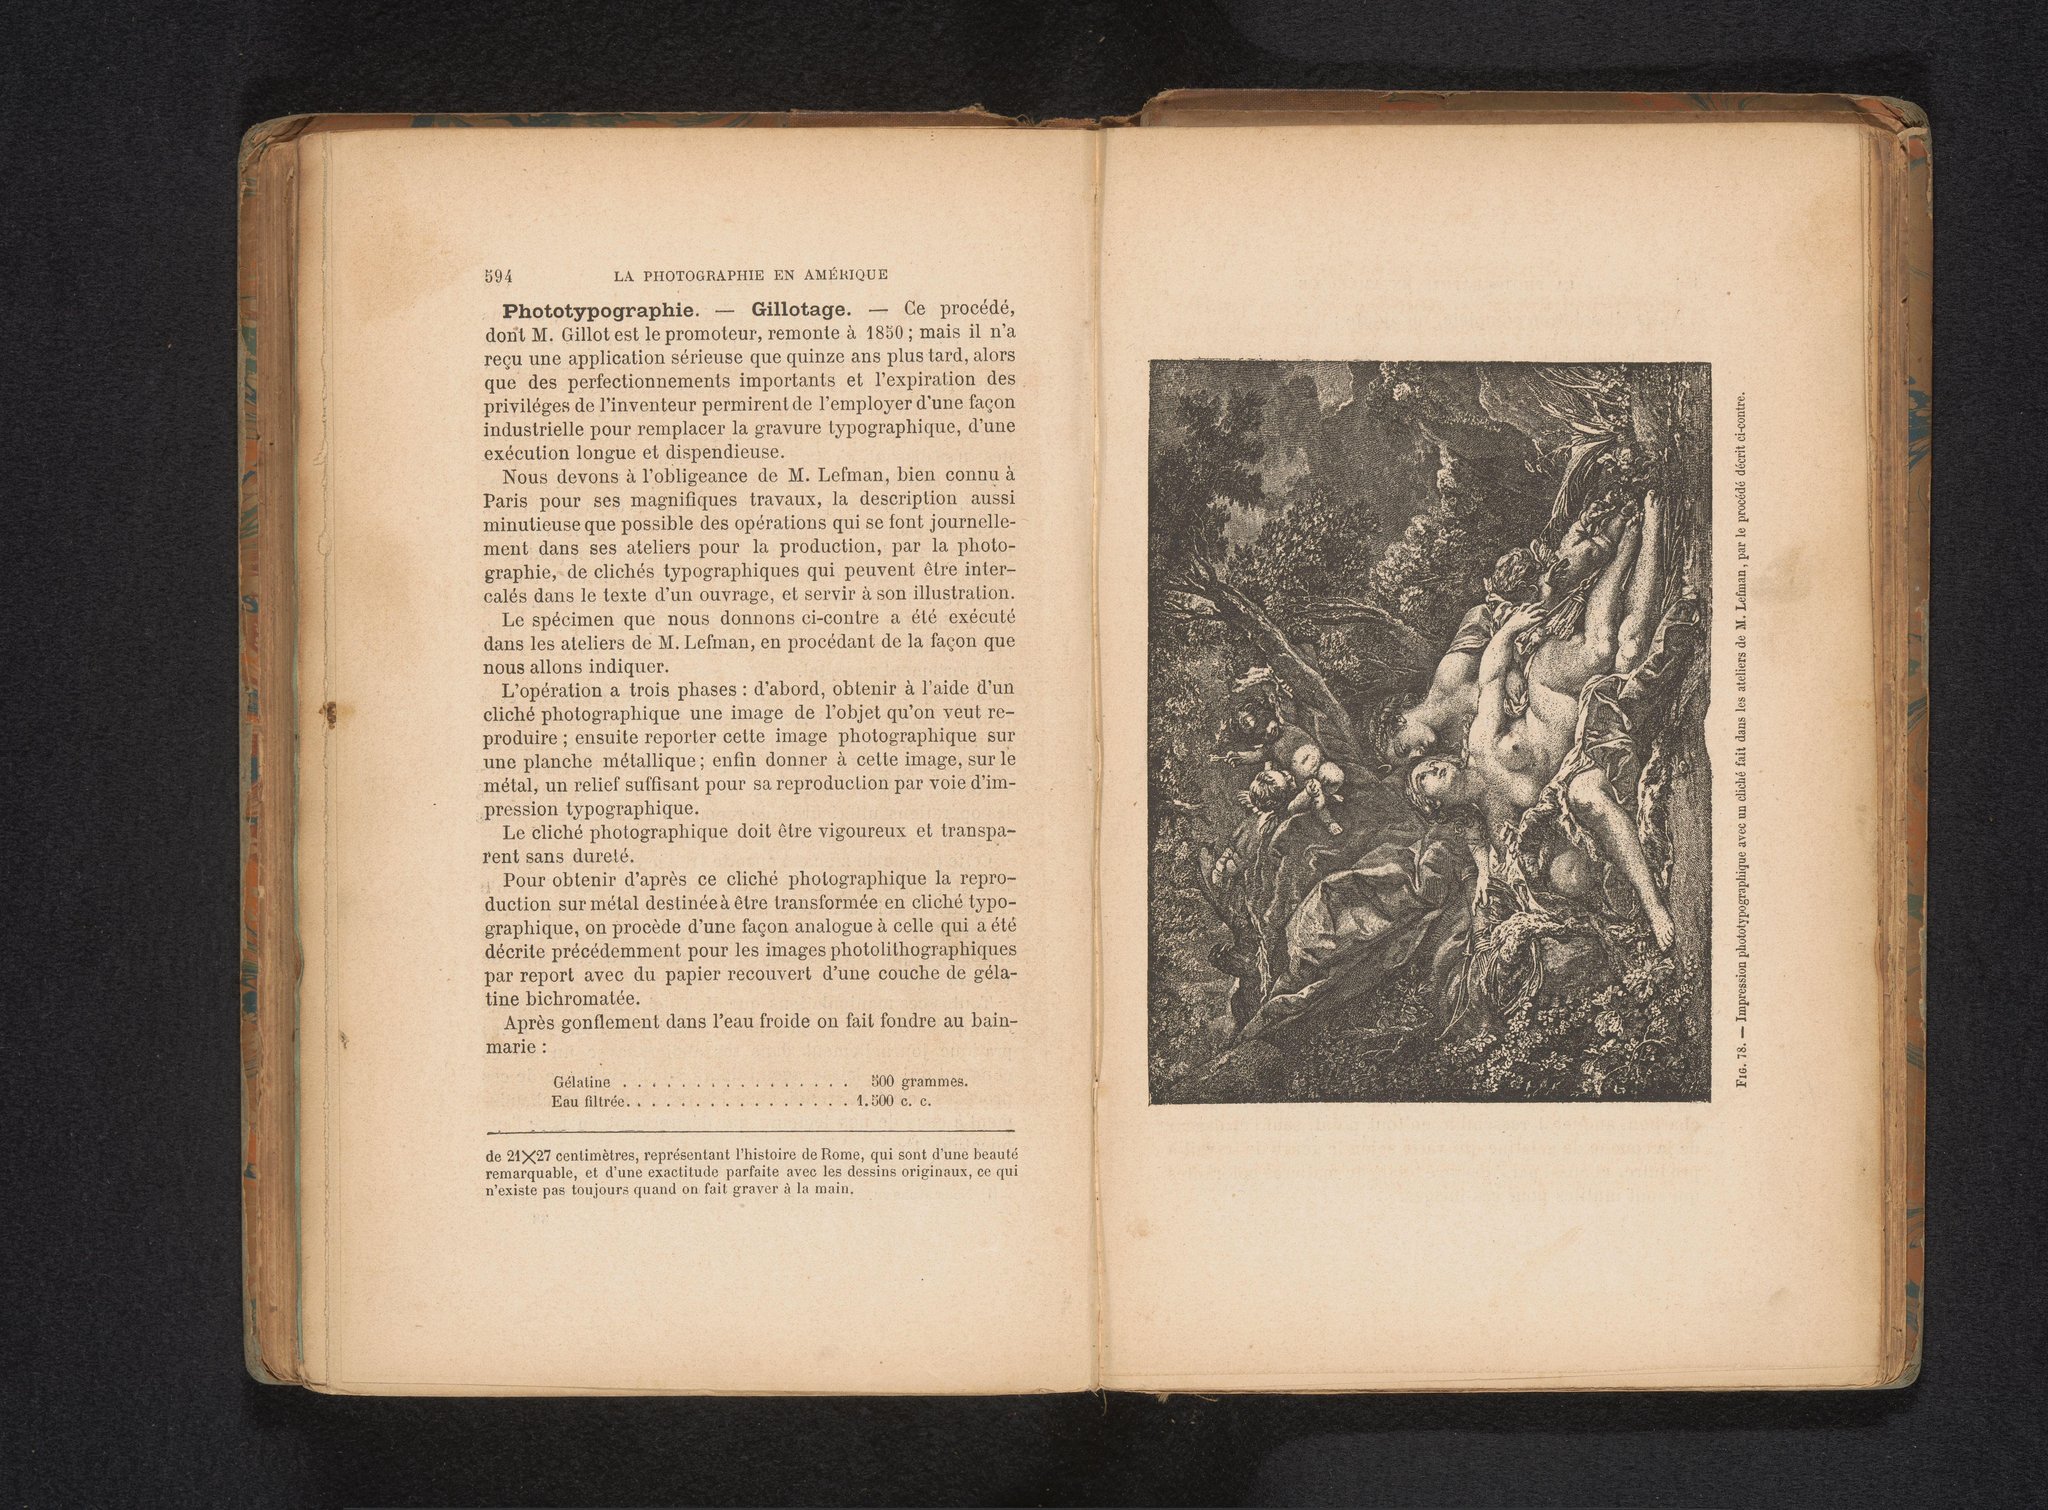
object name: page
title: Reproductie van een prent van een mythologische voorstelling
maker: m. lefman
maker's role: clichémaker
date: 1873-1878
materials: paper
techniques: printing block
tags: woman (showing herself) undressed, quasi-nude, cupids: 'amores', 'amoretti', 'putti'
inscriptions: inscription: ‘Fig. 78. - Impression phototypographique avec un cliché fait dans les ateliers de M. Lefman, par le procédé décrit ci-contre.’